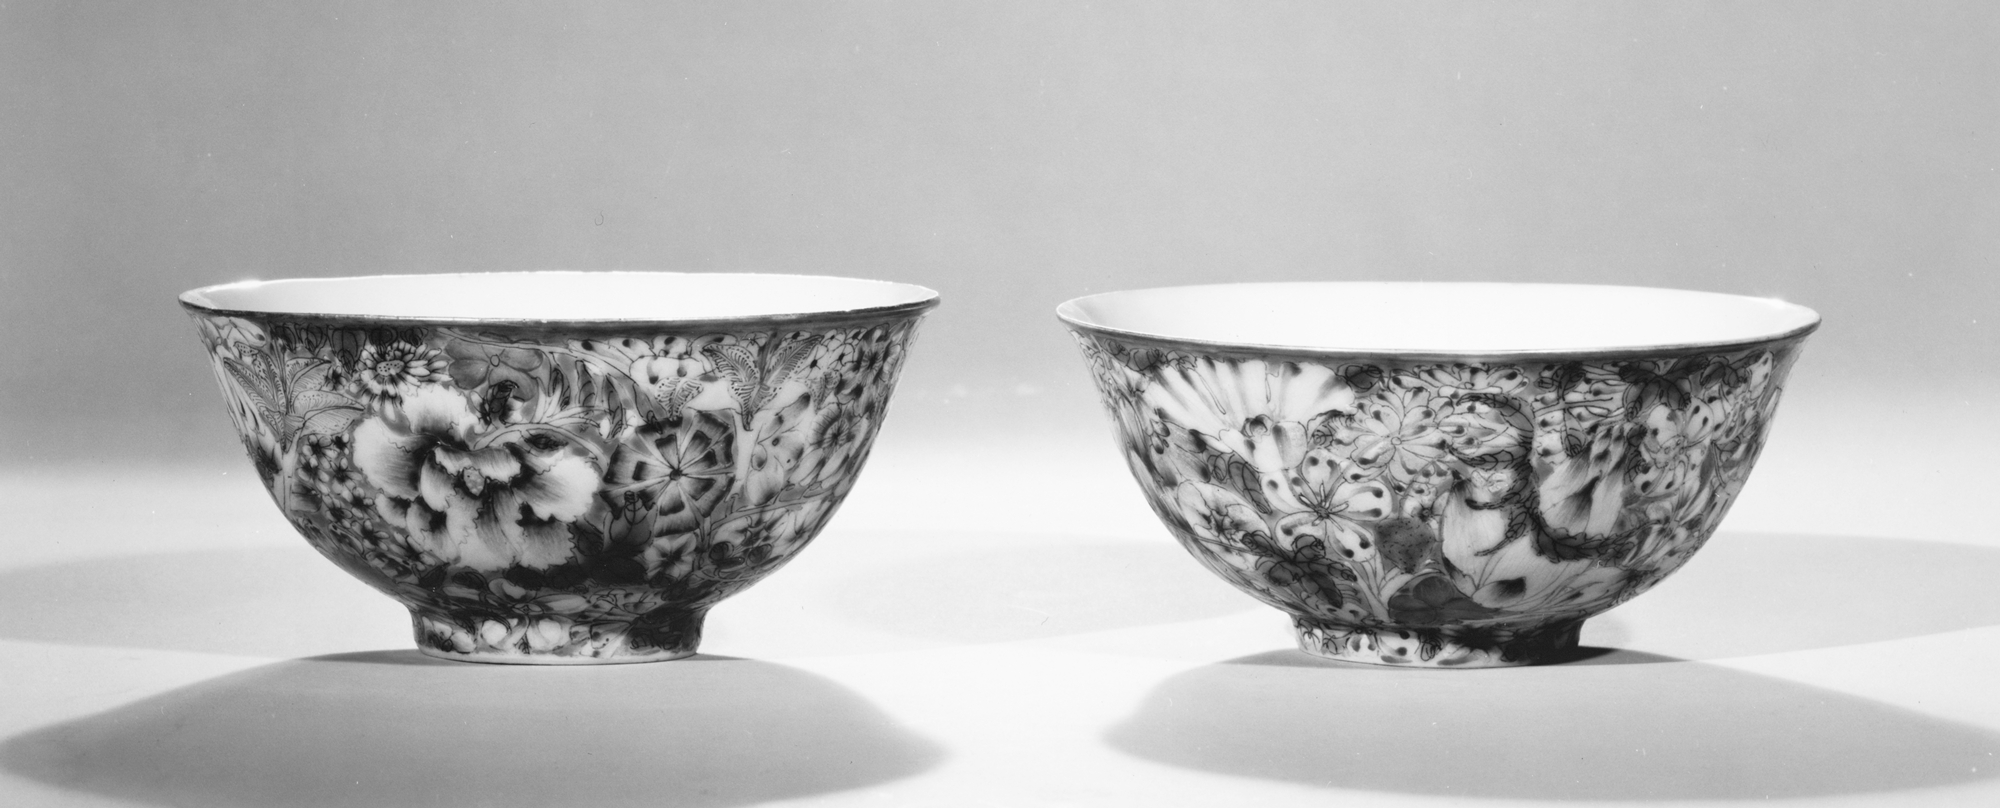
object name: bowl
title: Bowl (one of a pair)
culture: chinese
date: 1916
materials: porcelain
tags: flowers